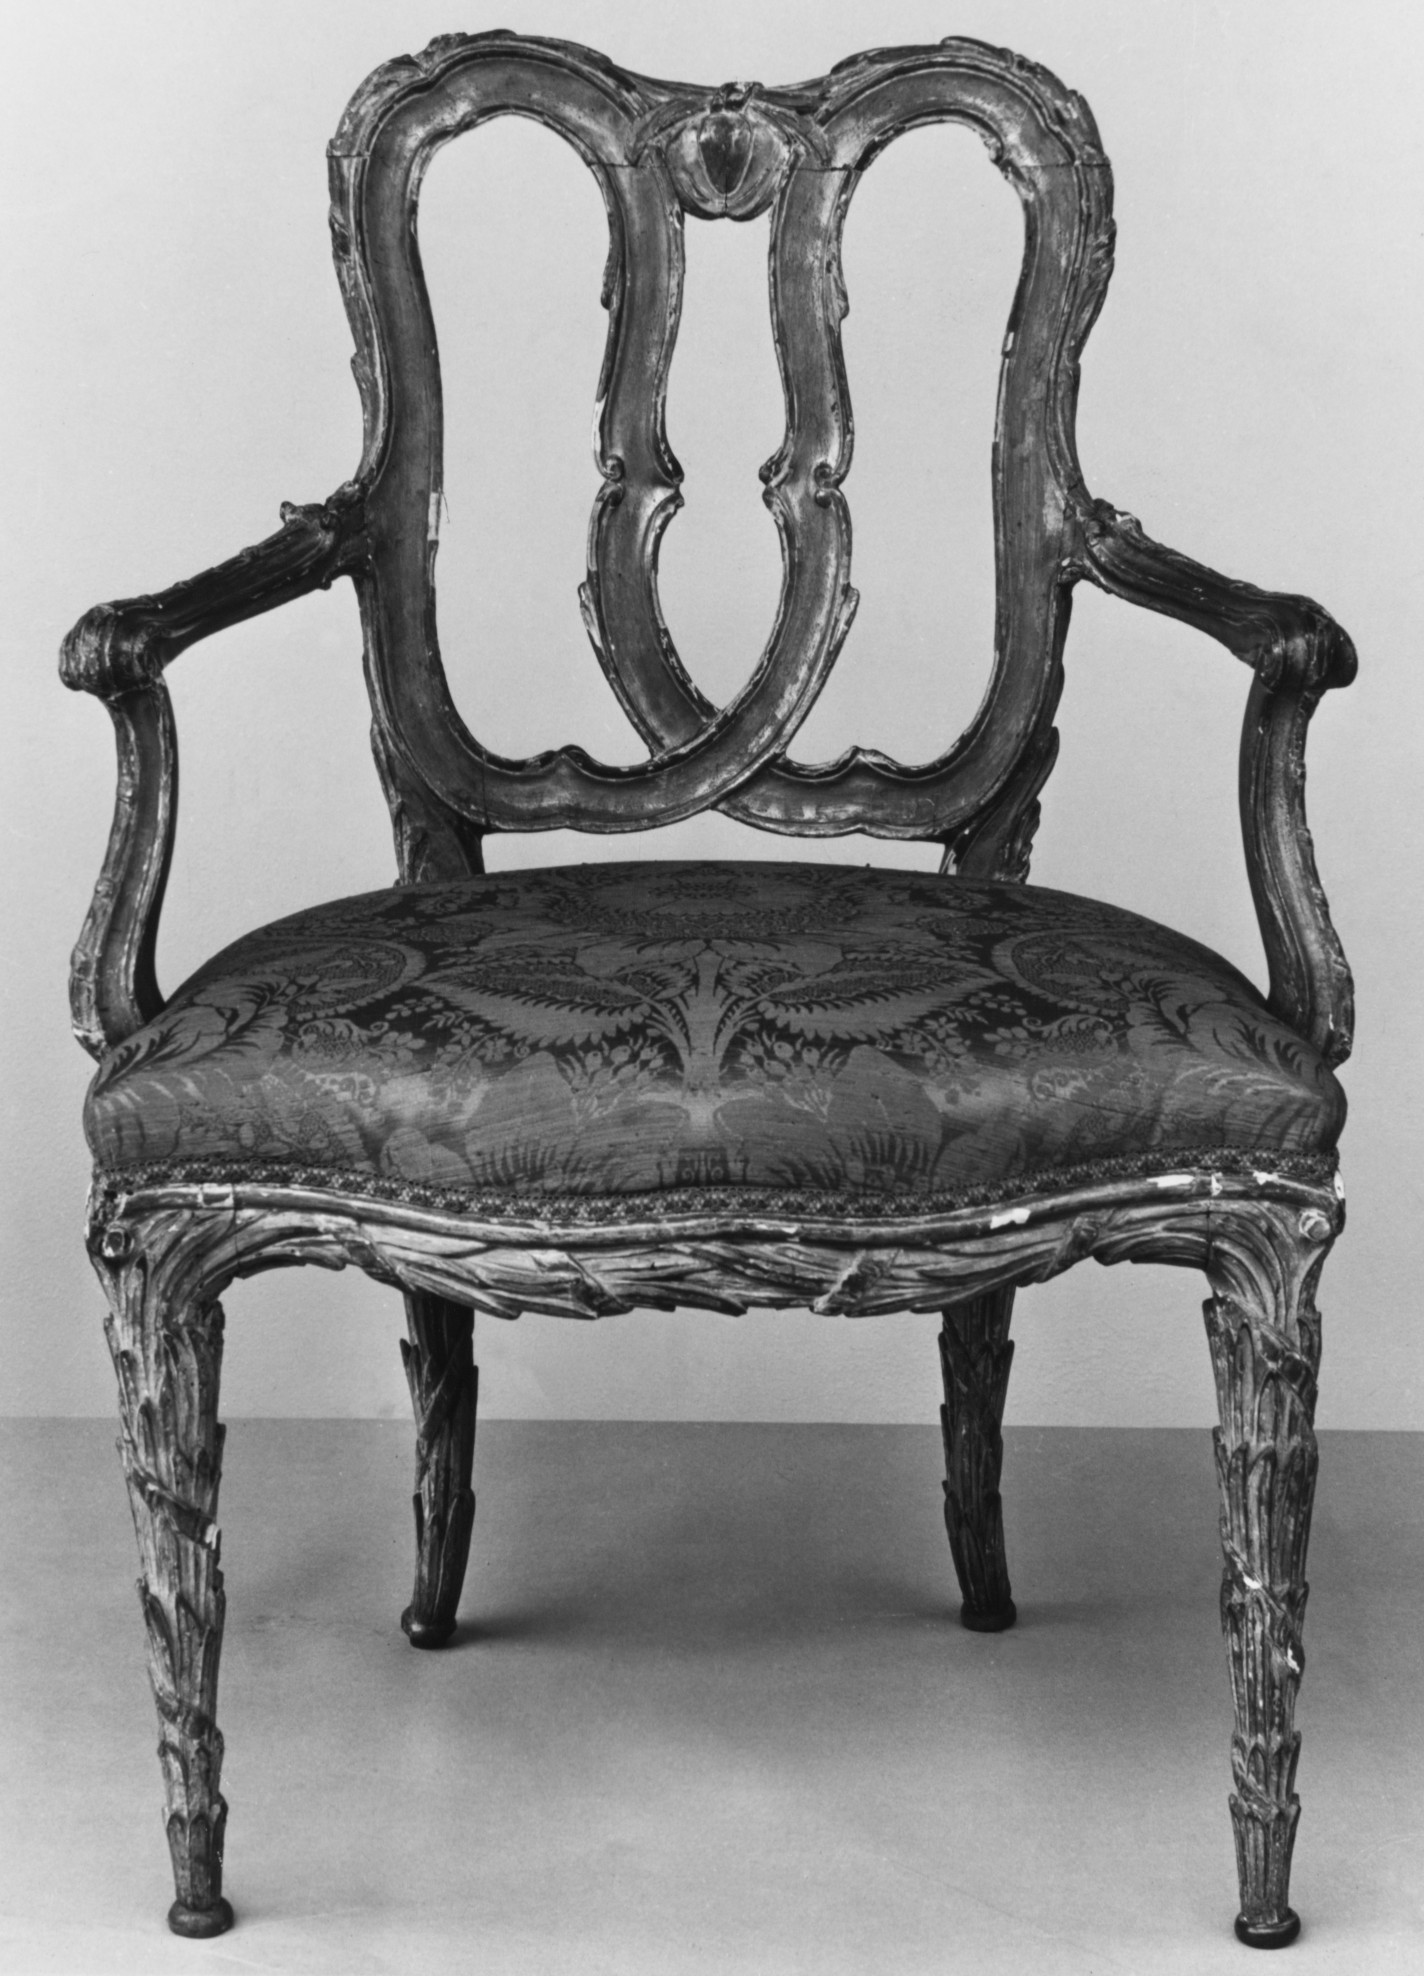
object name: armchair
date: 1751-1775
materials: wood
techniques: damask, gilding, painting